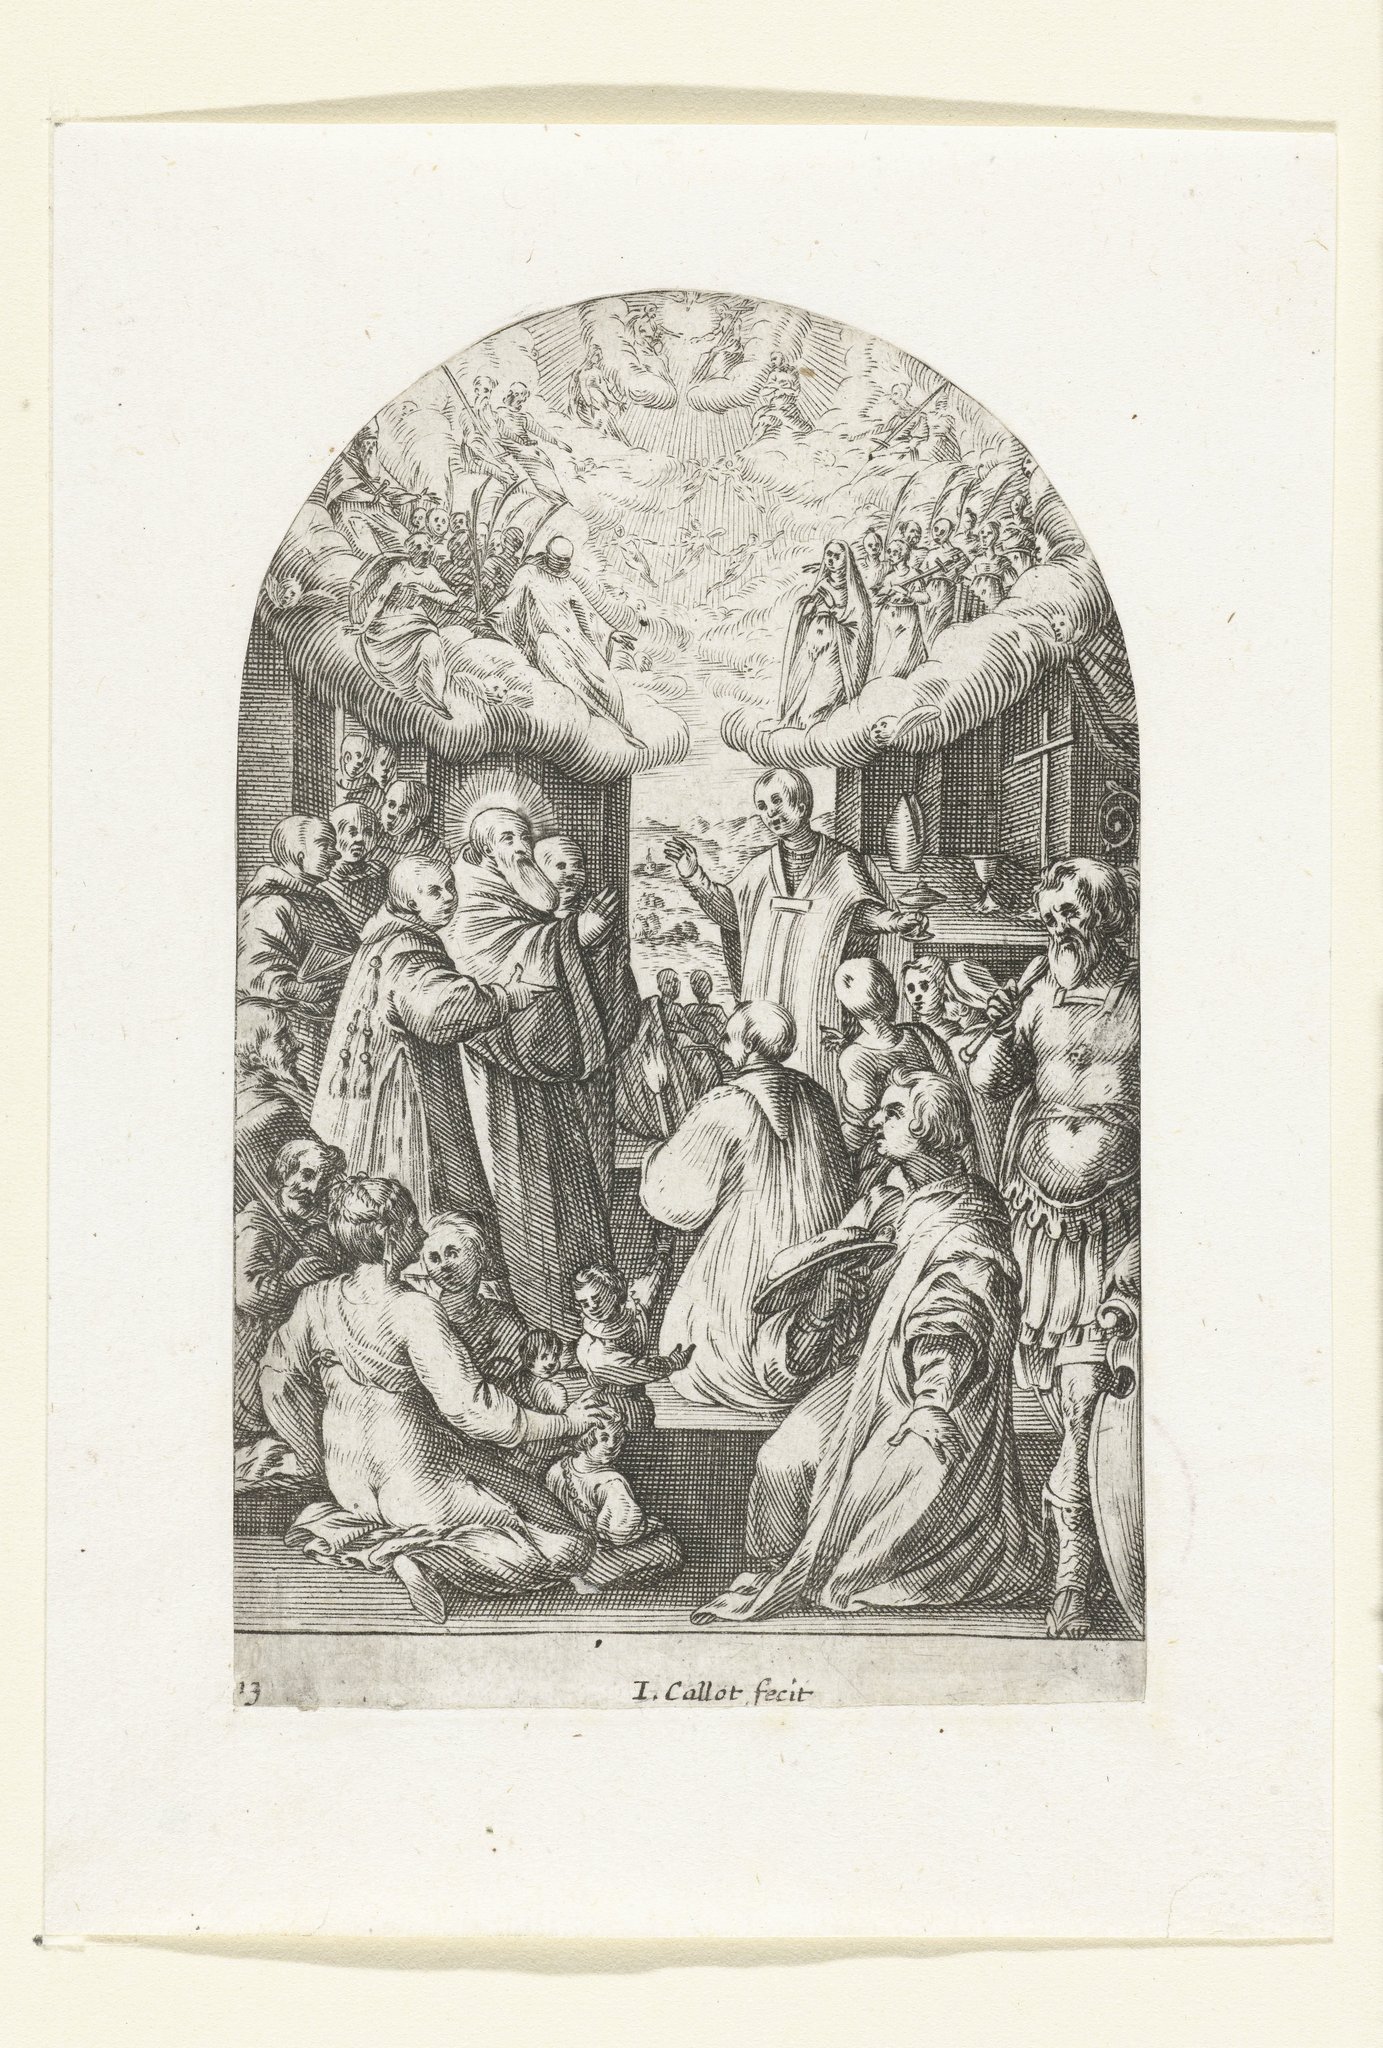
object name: print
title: Schilderijen en sculpturen te Rome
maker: jacques callot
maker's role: draughtsman, print maker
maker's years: 1592-1635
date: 1608-1611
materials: paper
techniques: engraving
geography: rome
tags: death of st. benedict: standing (sometimes before the open tomb of st. scholastica), supported by monks or angels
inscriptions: collector's mark: Lugt 240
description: Benedictus staat, ondersteund door twee geestelijken, tegenover een priester, die voor hem een eucharistieviering leidt. Vanuit de hemel kijken diverse martelaren en Maria toe. Deze prent is onderdeel van (de tweede staat van) een serie van 29 voorstellingen van schilderijen en sculpturen in kerken te Rome, genummerd 1-16 en 1-13. (De eerste staat van deze serie, waarin de prenten ongenummerd zijn, behelst ook een titelprent.